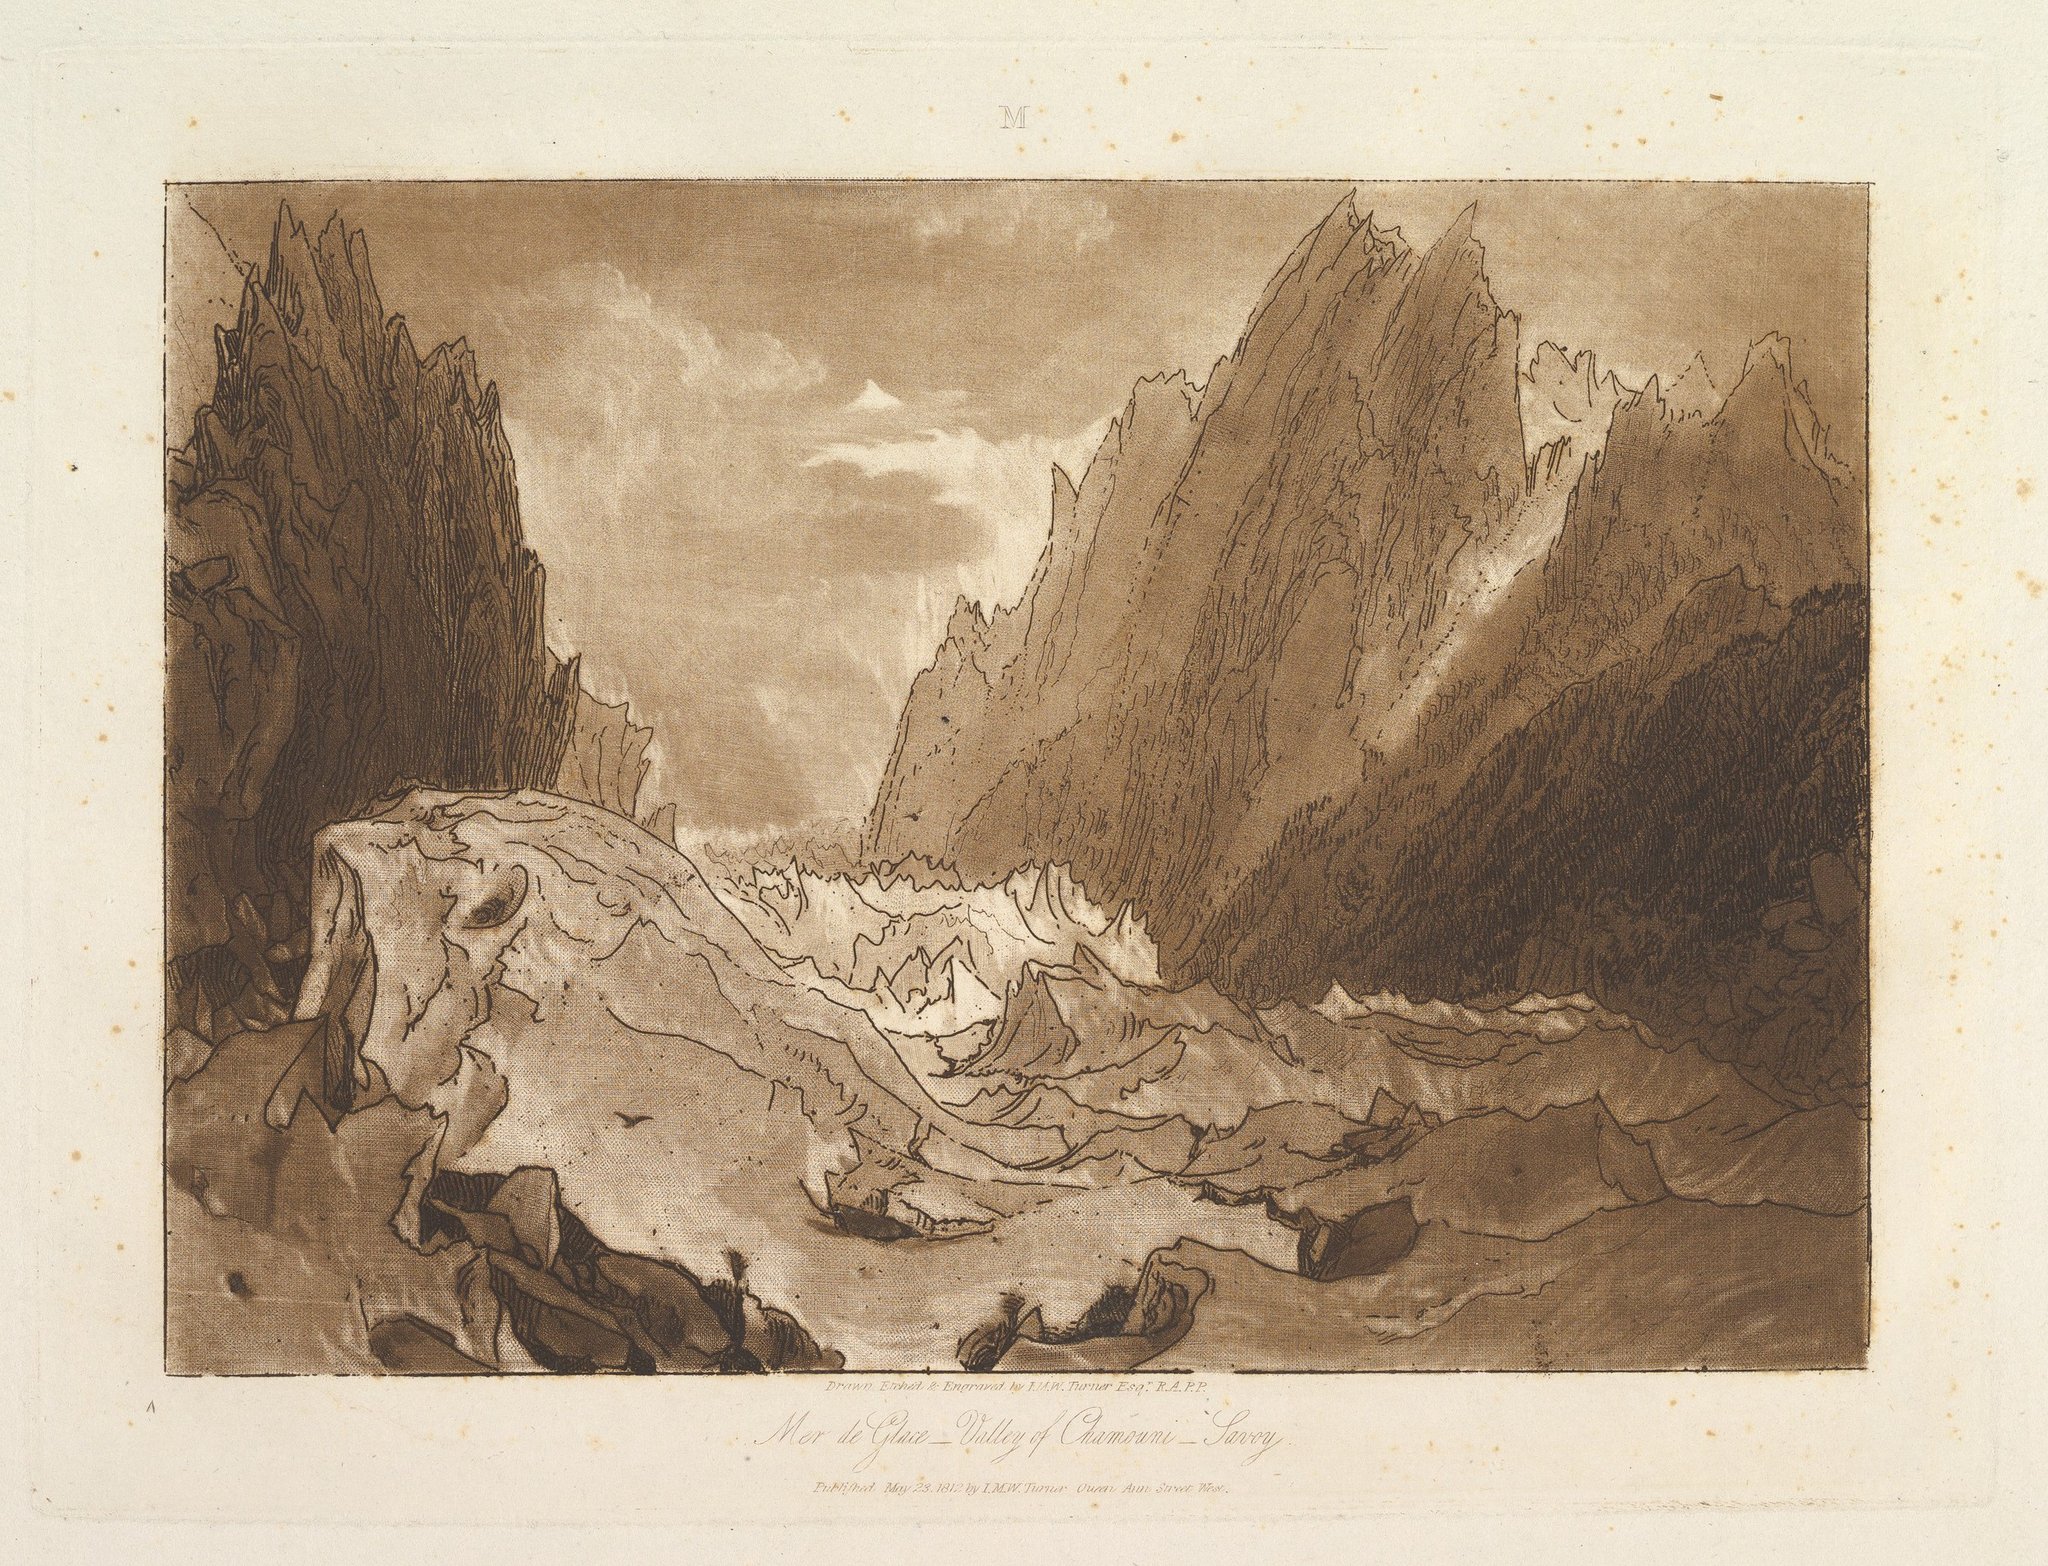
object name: print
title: Mêr de Glace, Valley of Chamouni-Savoy, part X, plate 50 from "Liber Studiorum"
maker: joseph mallord william turner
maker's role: artist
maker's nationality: british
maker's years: 1775-1851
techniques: etching, mezzotint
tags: mountains,landscapes